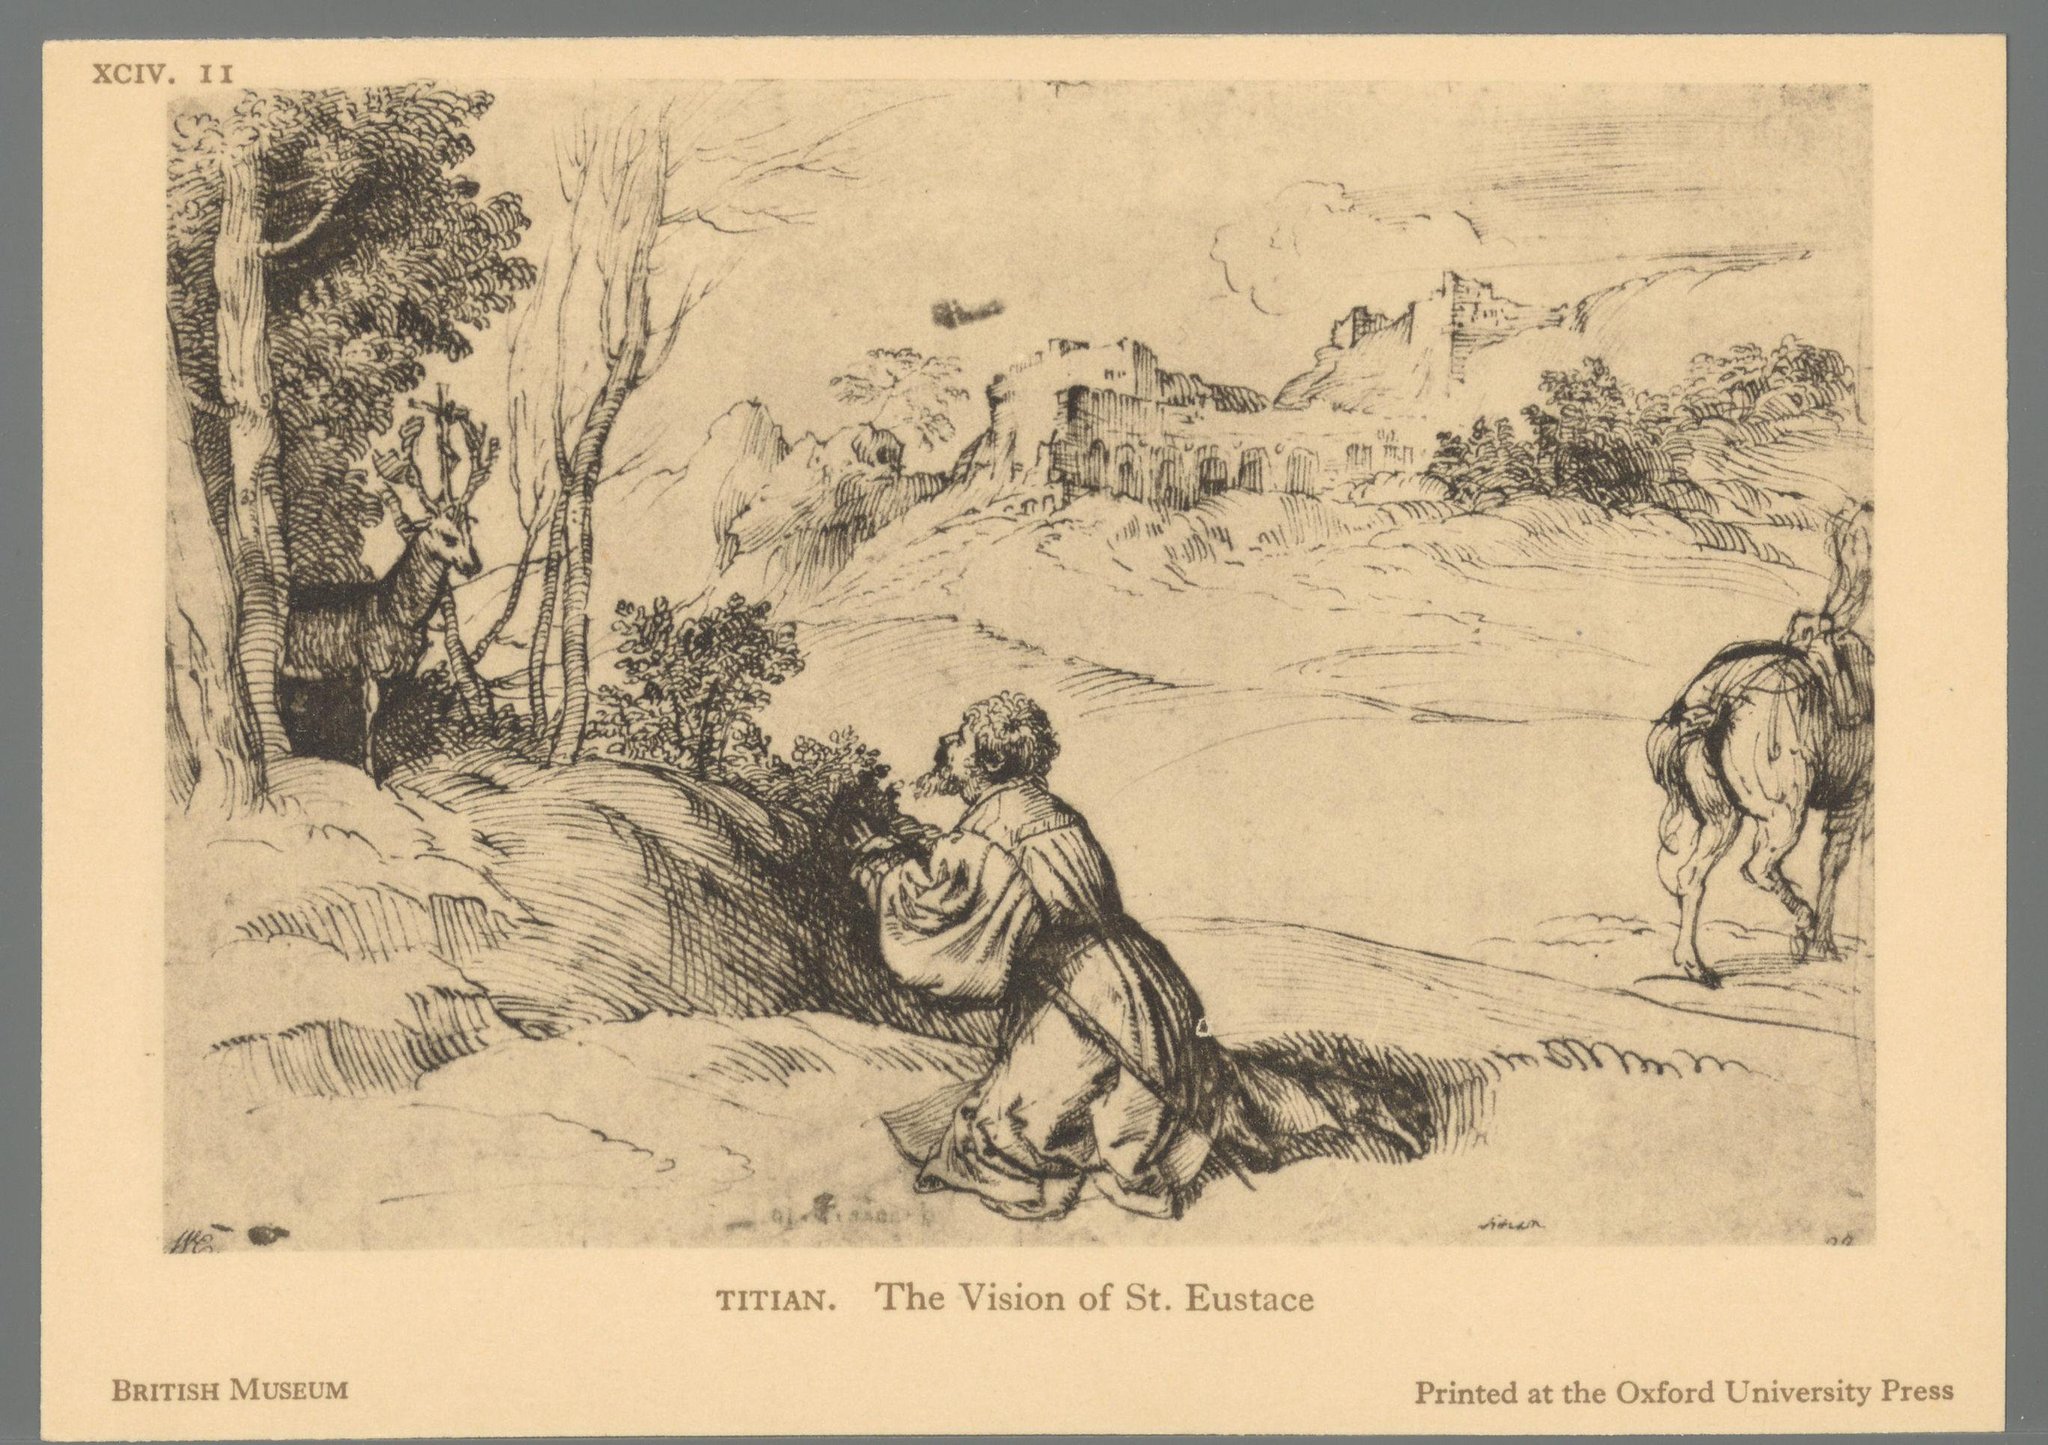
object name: reproduction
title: Titian. The Vision of St. Eustace. British Museum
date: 1902-1950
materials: cardboard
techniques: photograph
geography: oxford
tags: drawing, sketch, permanent exhibition, museum